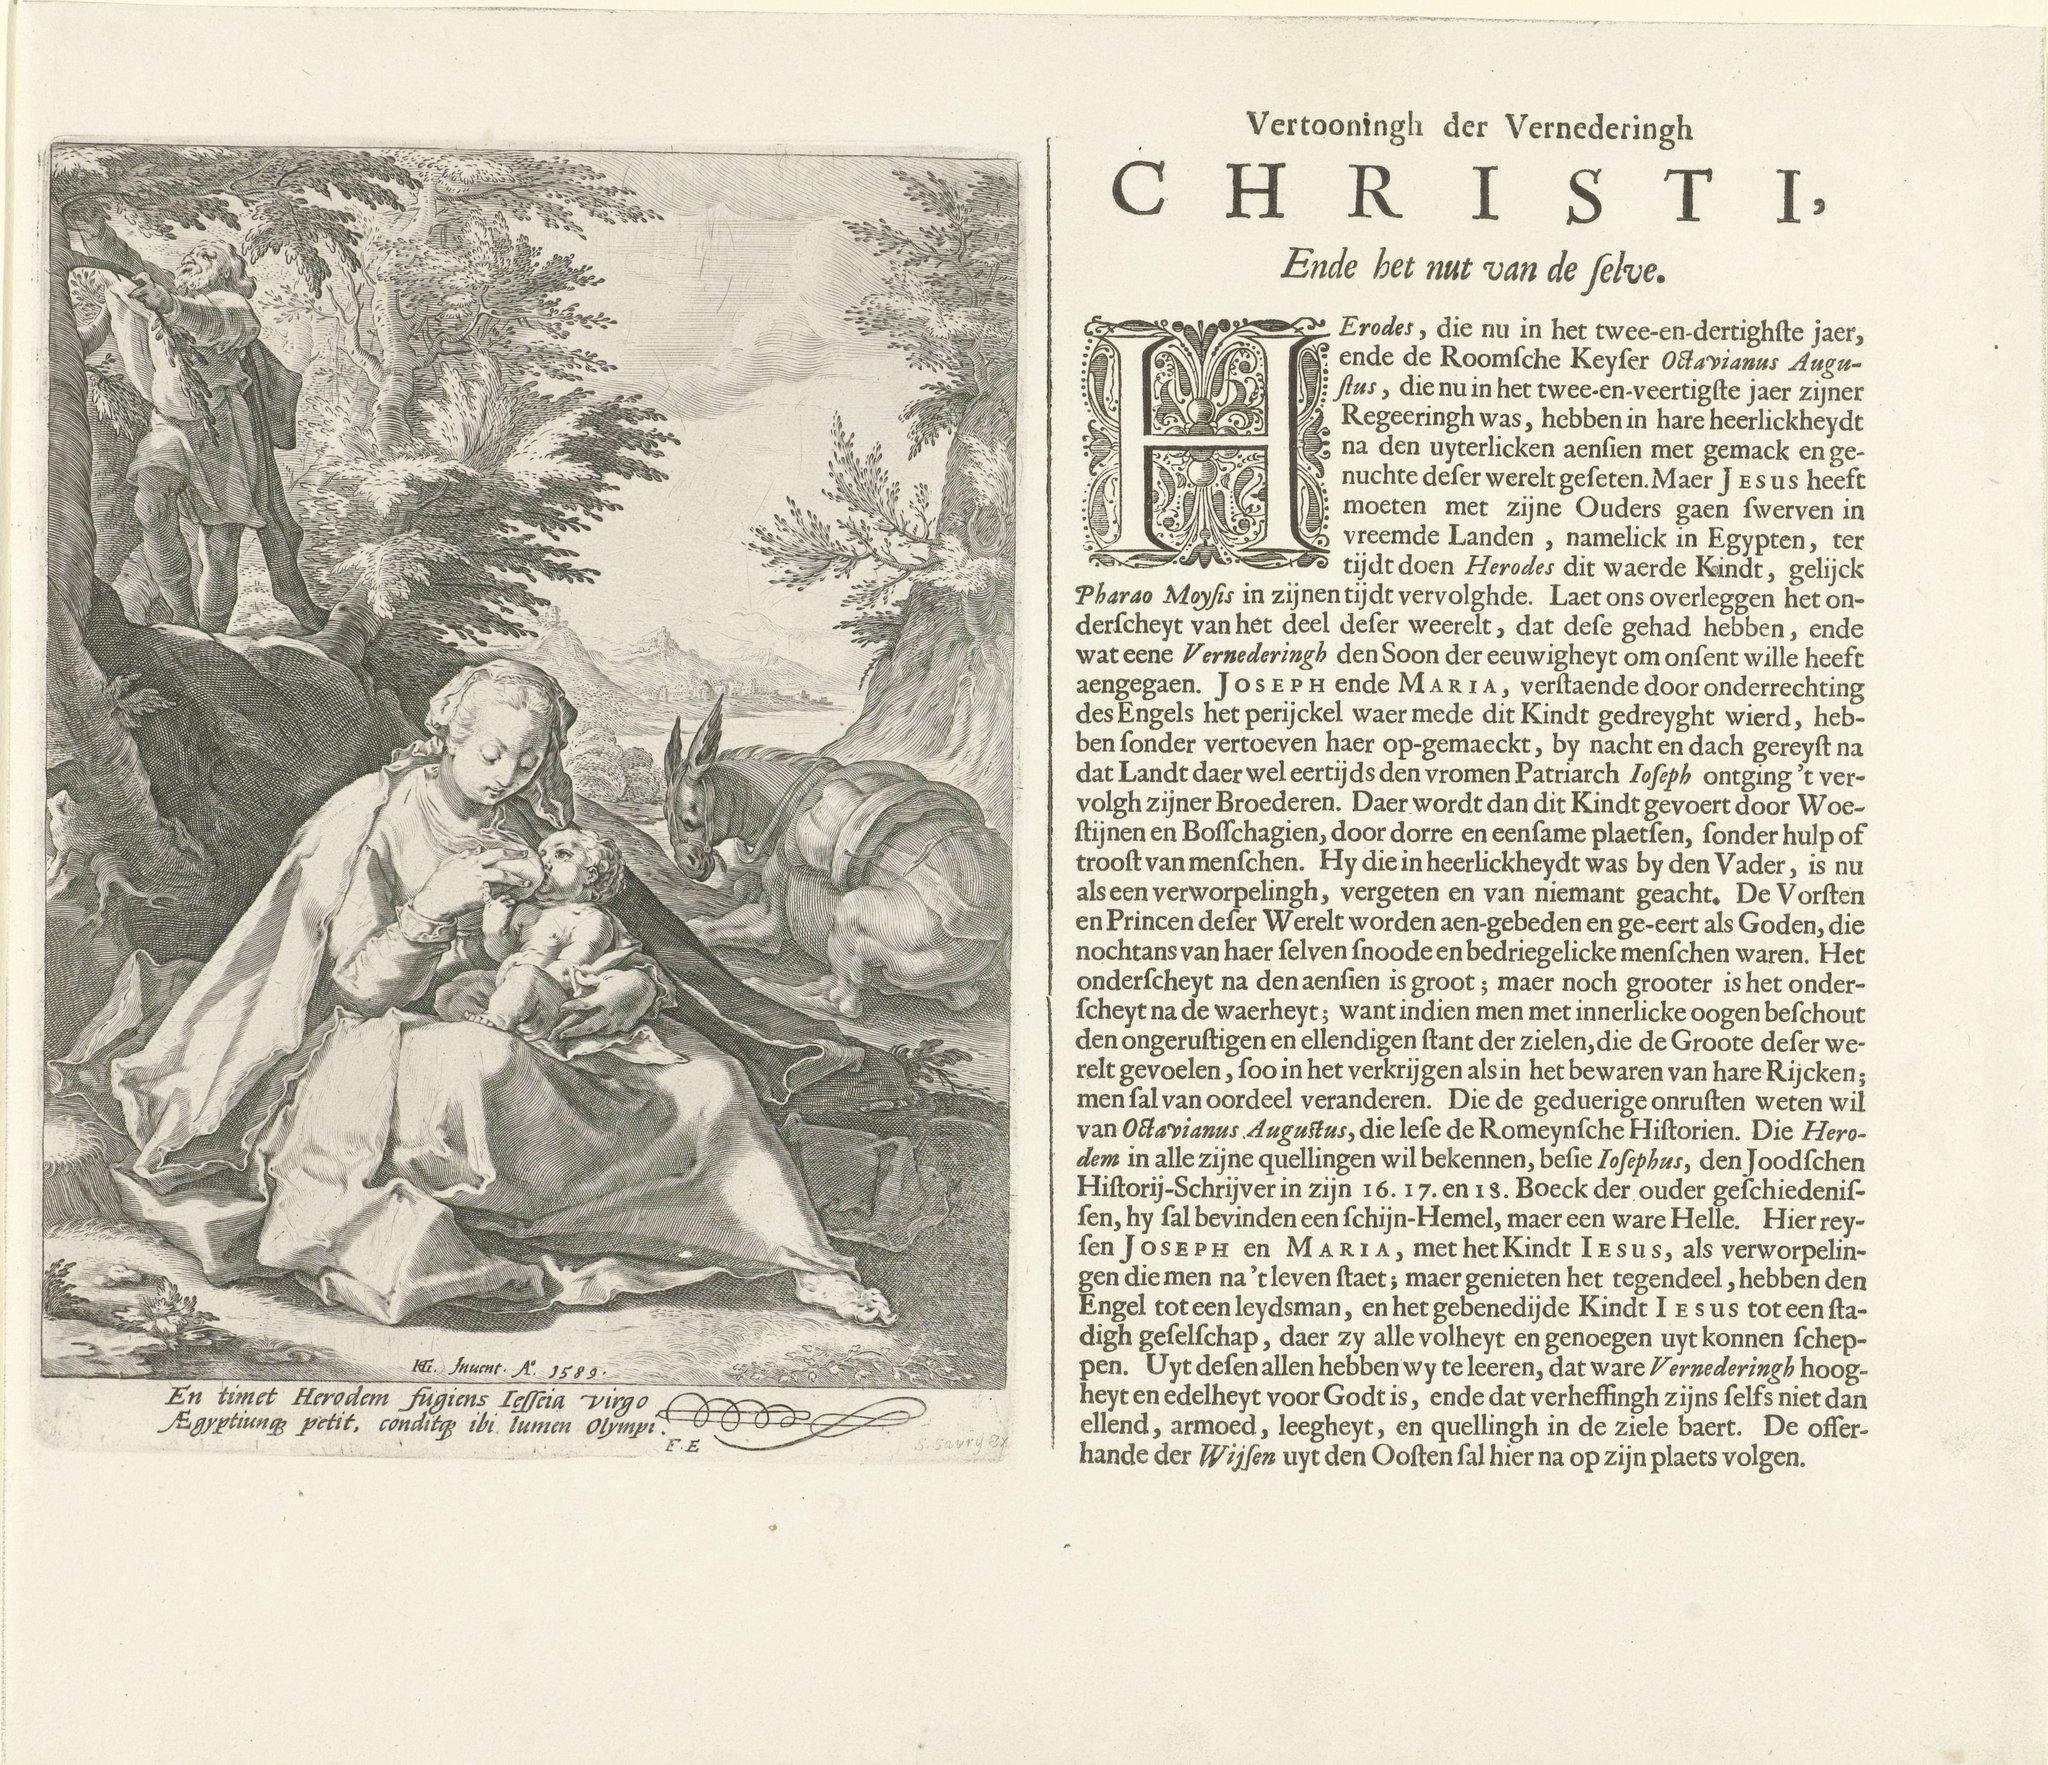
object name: print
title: Rest on the Flight into Egypt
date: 1589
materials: paper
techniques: engraving, letterpress printing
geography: haarlem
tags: rest on the flight into egypt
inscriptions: collector's mark: Lugt 240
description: Maria geeft het Christuskind de borst tijdens de rust op de vlucht naar Egypte. Een doorkijk naar een rivierlandschap in de achtergrond.